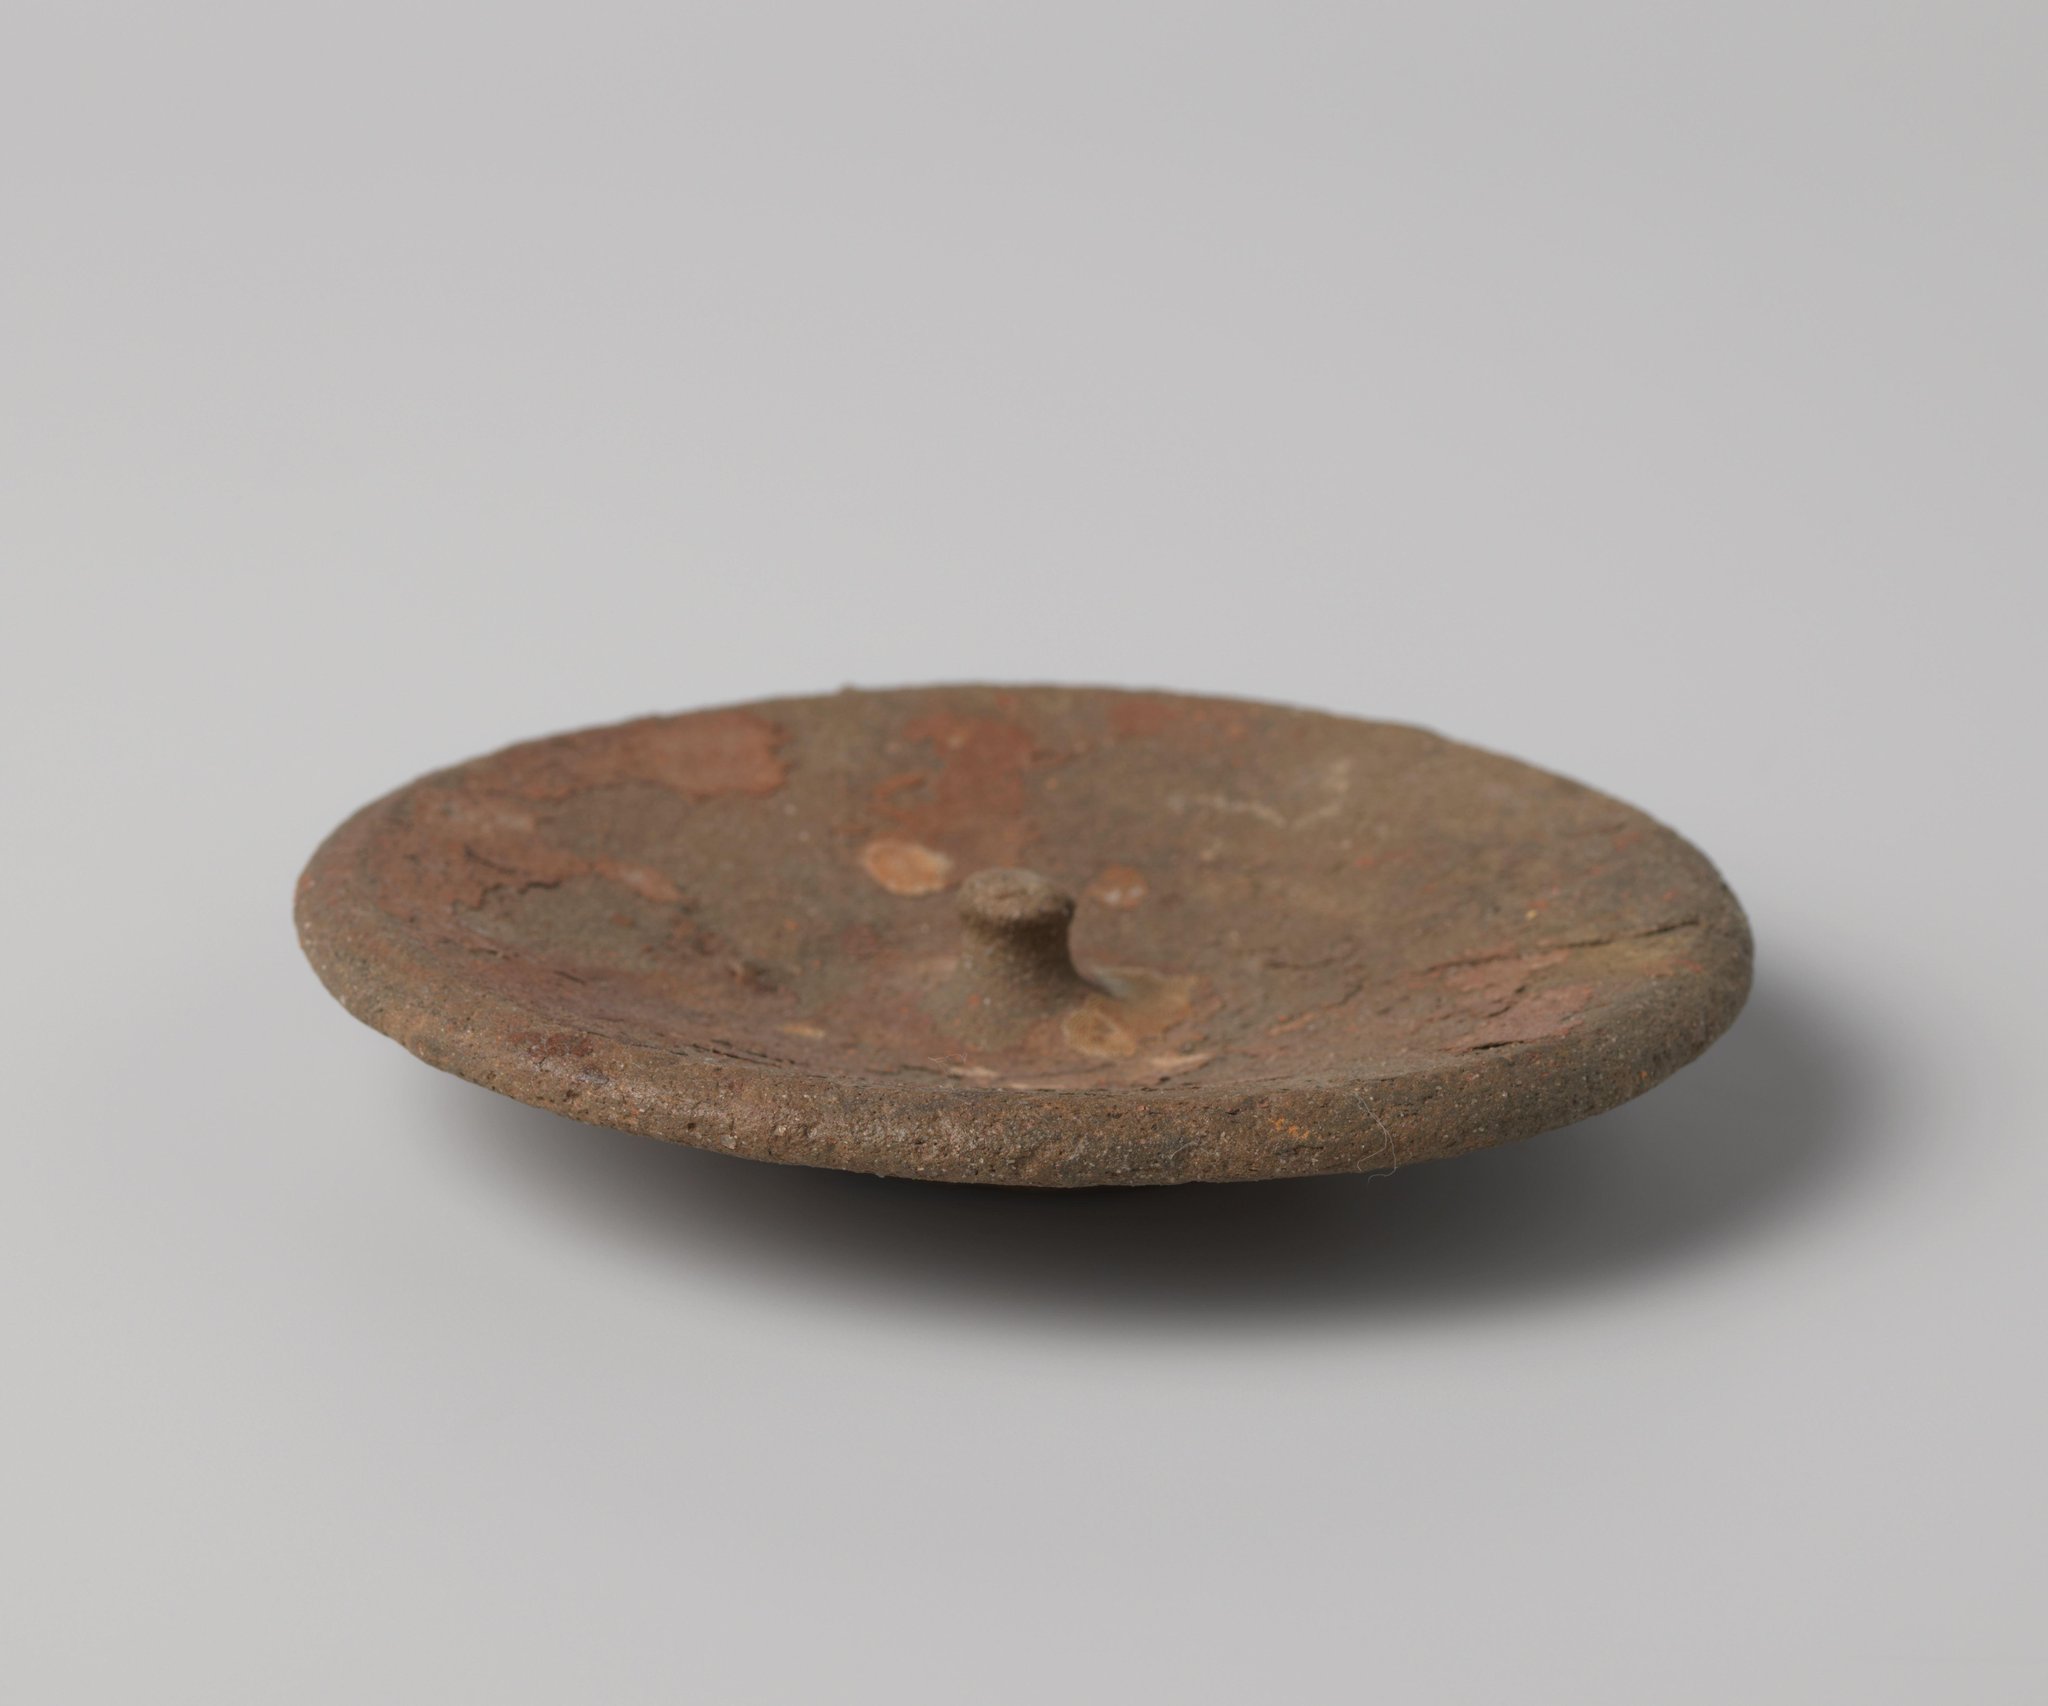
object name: martavaan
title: Deksel van een martavaan uit V.O.C.-schip de 'Witte Leeuw'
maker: Anonymous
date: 1613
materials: earthenware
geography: southeast asia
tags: verenigde oostindische compagnie, sint-helena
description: An earthenware cover. The round cover have a concave base and usually a knob on top. The clay is orange red, brown, grey or cream-coloured and contains impurities. The inside of the covers show signs of scratches indicating that a sharp tool has been used to even out the clay. The body is coloured greyish-brown with white specks. On the top a conical shaped knob.